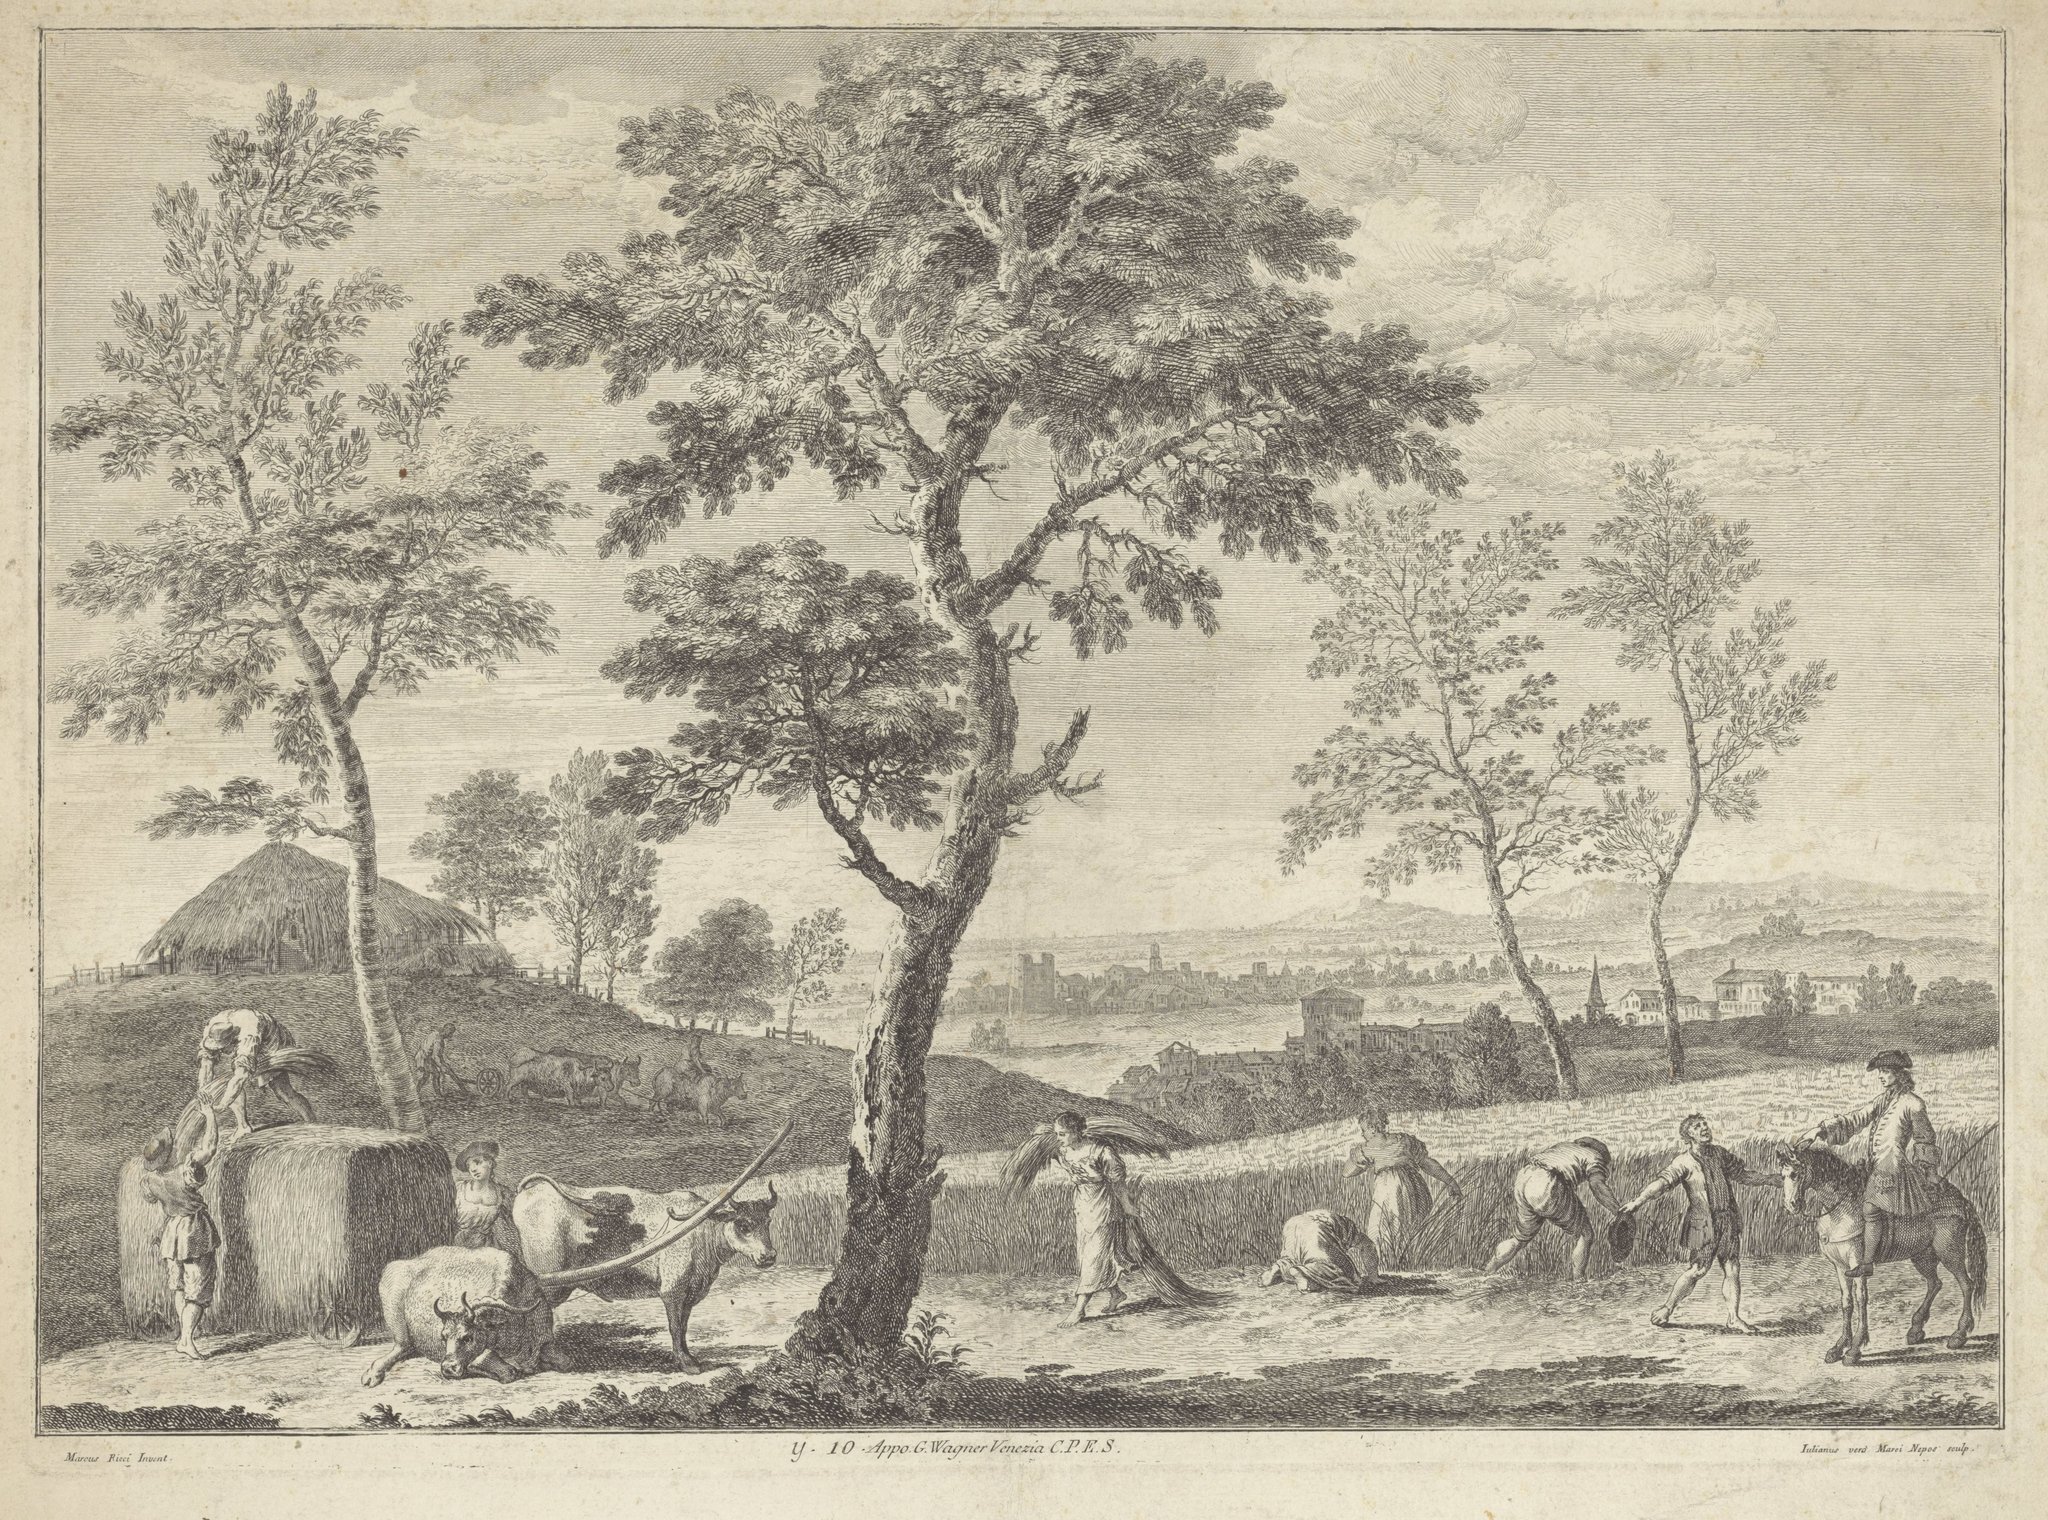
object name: print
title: Landschap met graanoogst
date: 1708-1759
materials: paper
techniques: etching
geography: italy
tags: farmers, cereal, grain, corn (grass with grains, grown for food, e.g.: wheat, rice, rye, oats, maize, buckwheat, millet), agriculture, ploughing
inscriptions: collector's mark: Lugt 2228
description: Een rivierlandschap met op de voorgrond een groep boeren en boerinnen die met behulp van ossen graan oogsten en een veld ploegen.